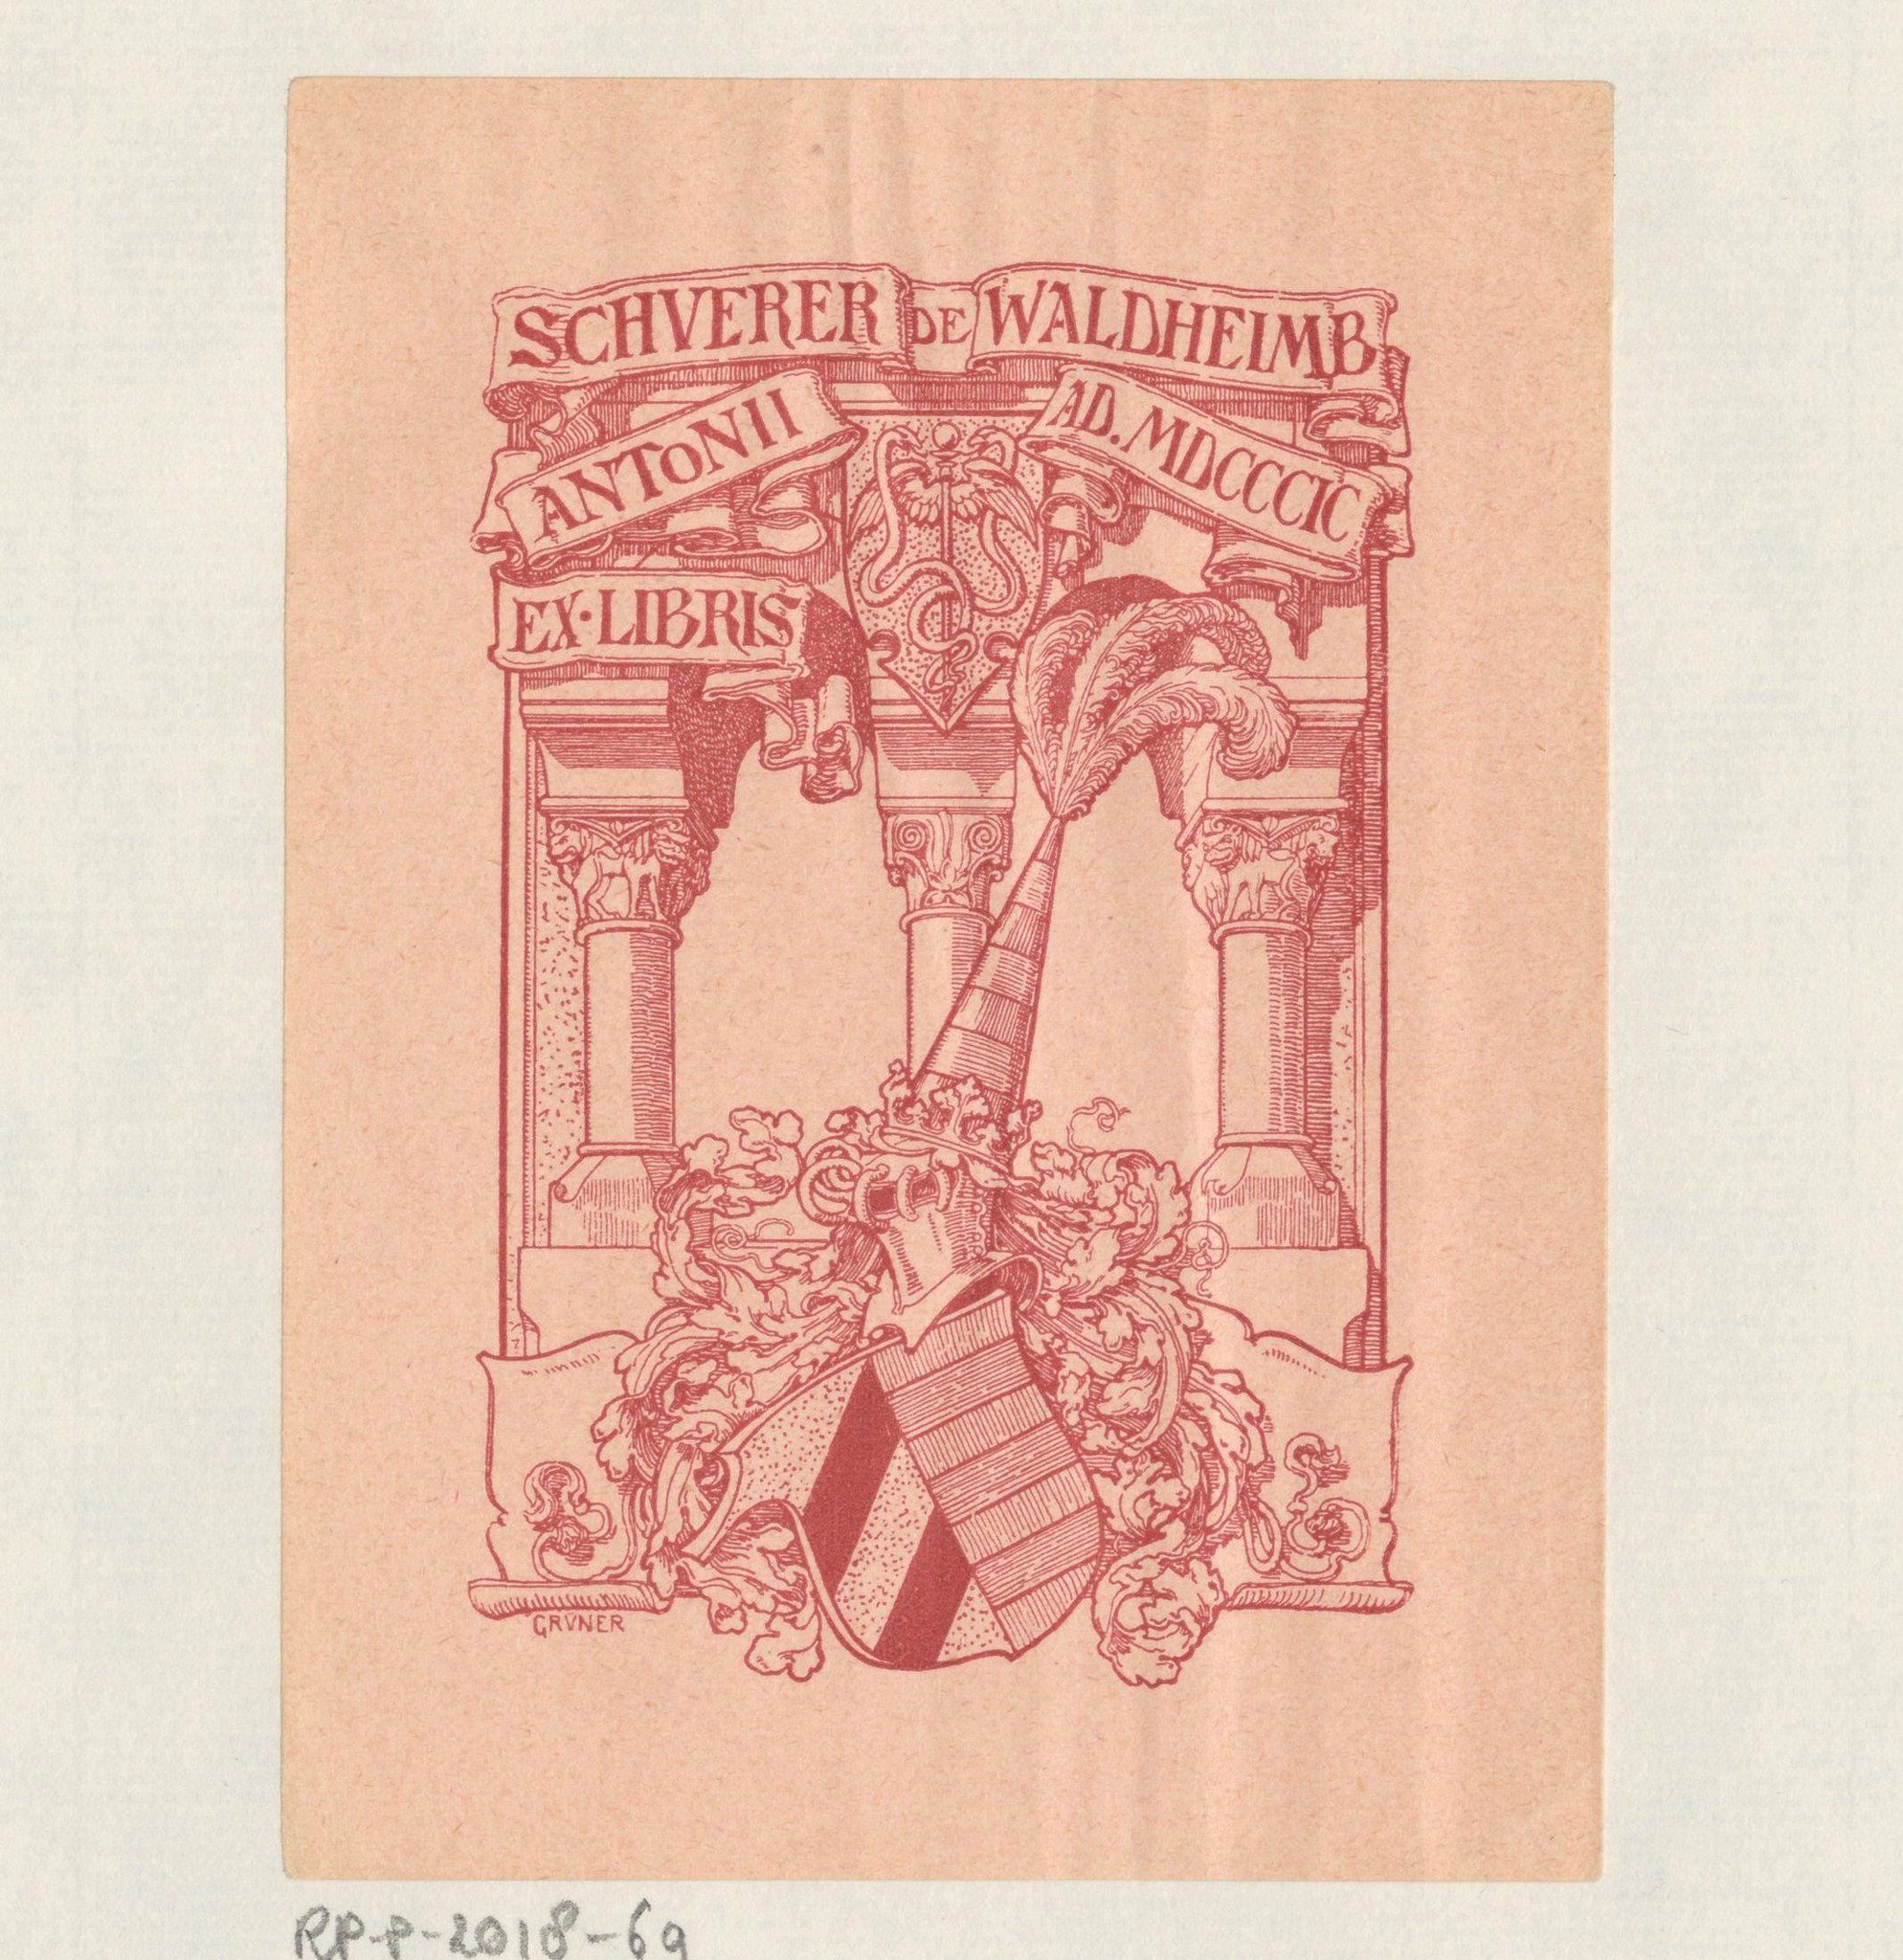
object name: bookplate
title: Ex libris van Anton Schürer von Waldheim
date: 1889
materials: paper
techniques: printing block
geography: germany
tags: column, pillar ~ architecture, caduceus (staff with two snakes, attribute of mercury), armorial bearing, heraldry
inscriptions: date